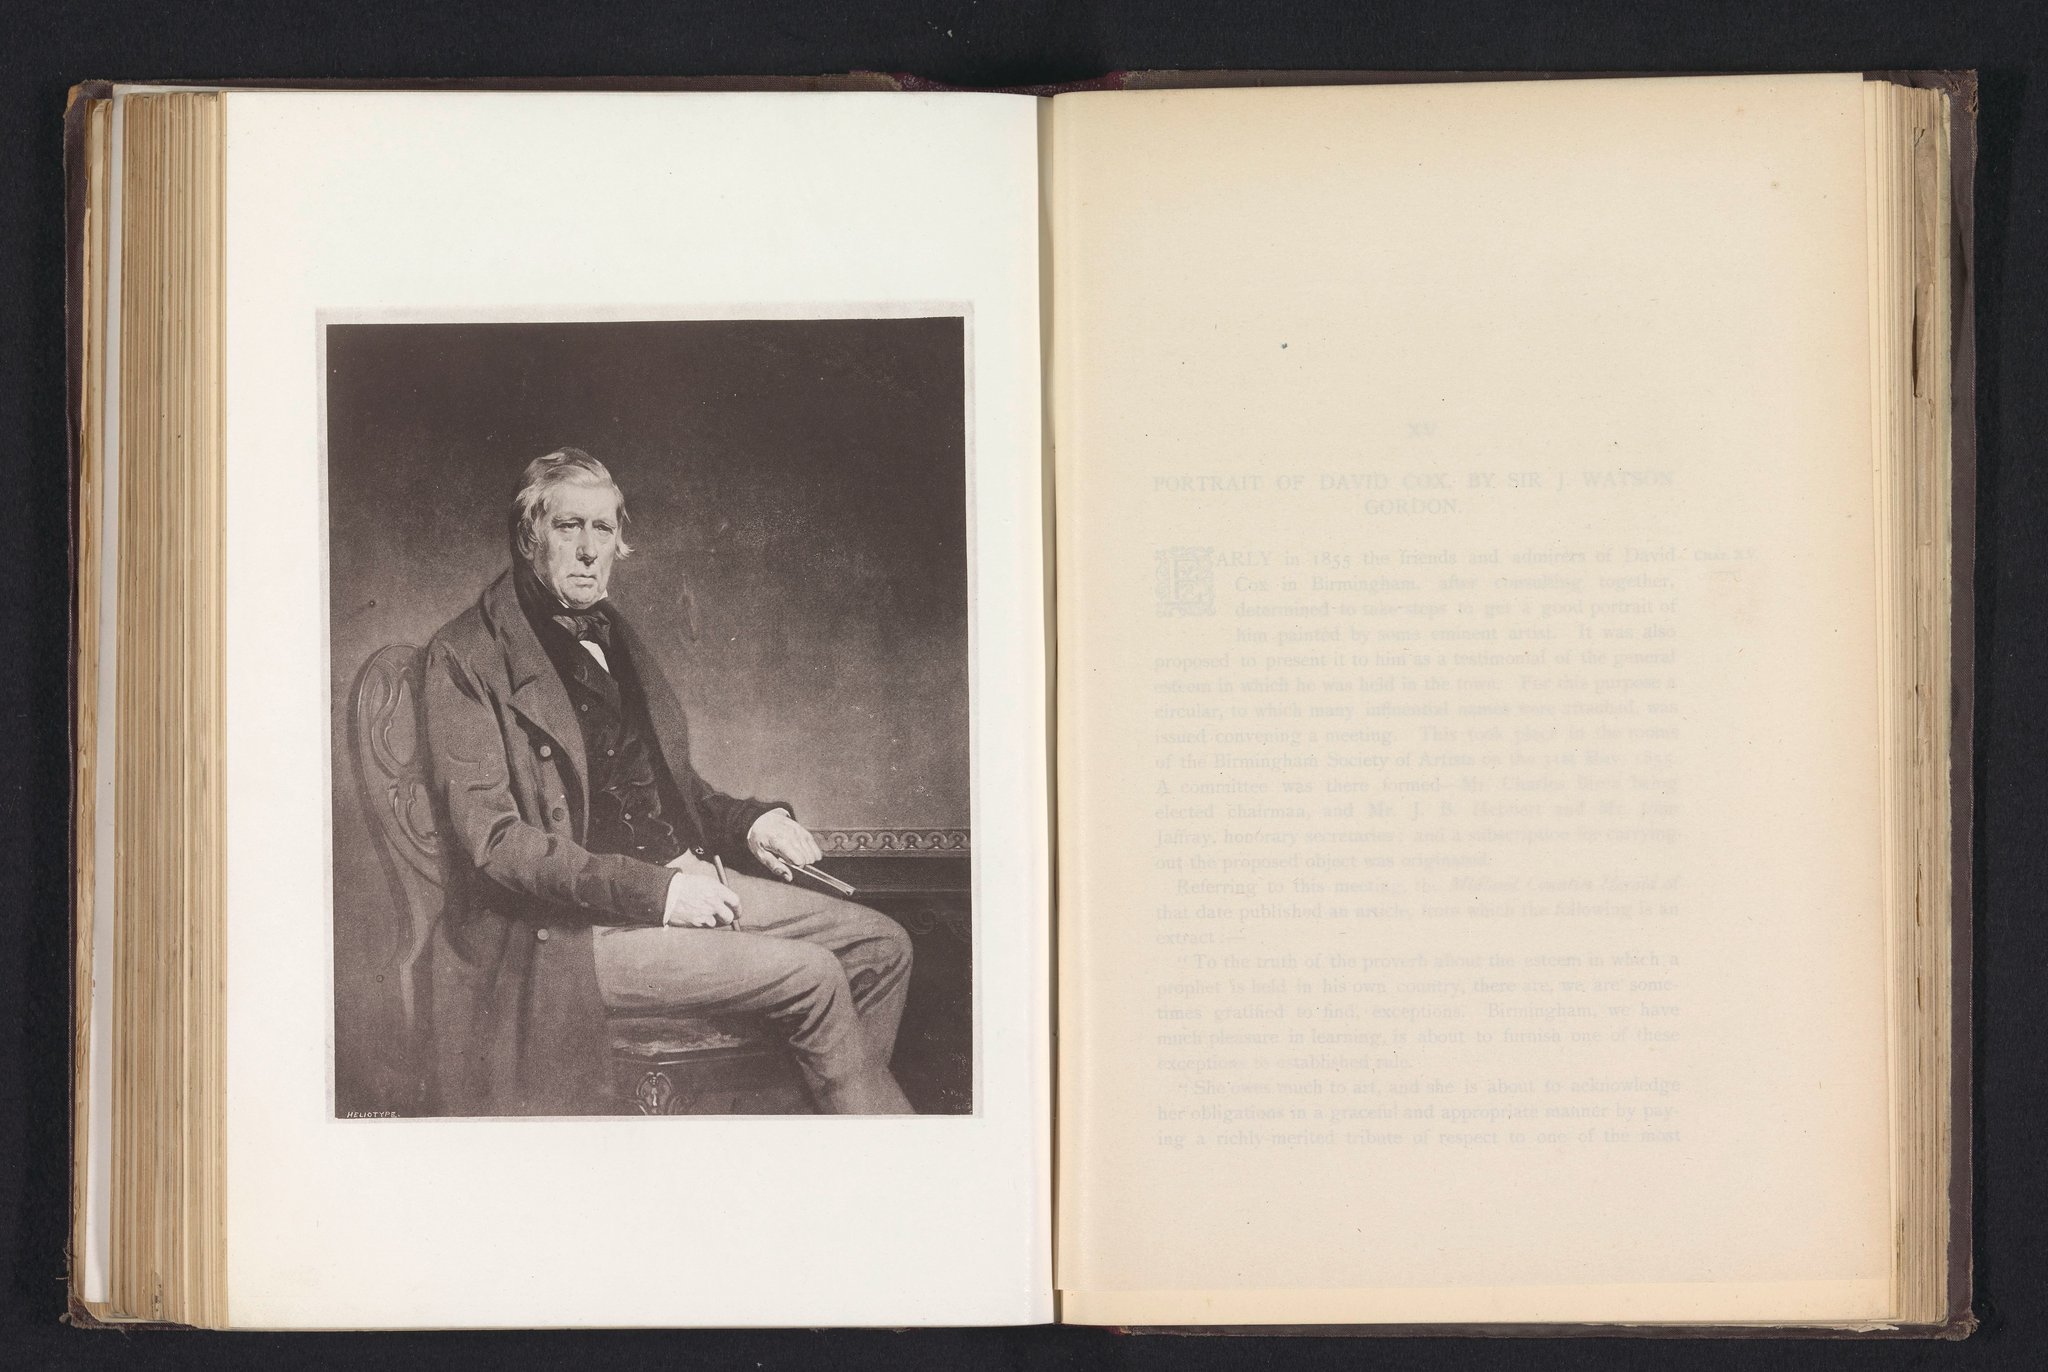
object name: reproduction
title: Fotoreproductie van een portret van David Cox door John Watson Gordon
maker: Anonymous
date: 1863-1873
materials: paper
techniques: photoaquatint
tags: portrait, self-portrait of painter, picture, painting